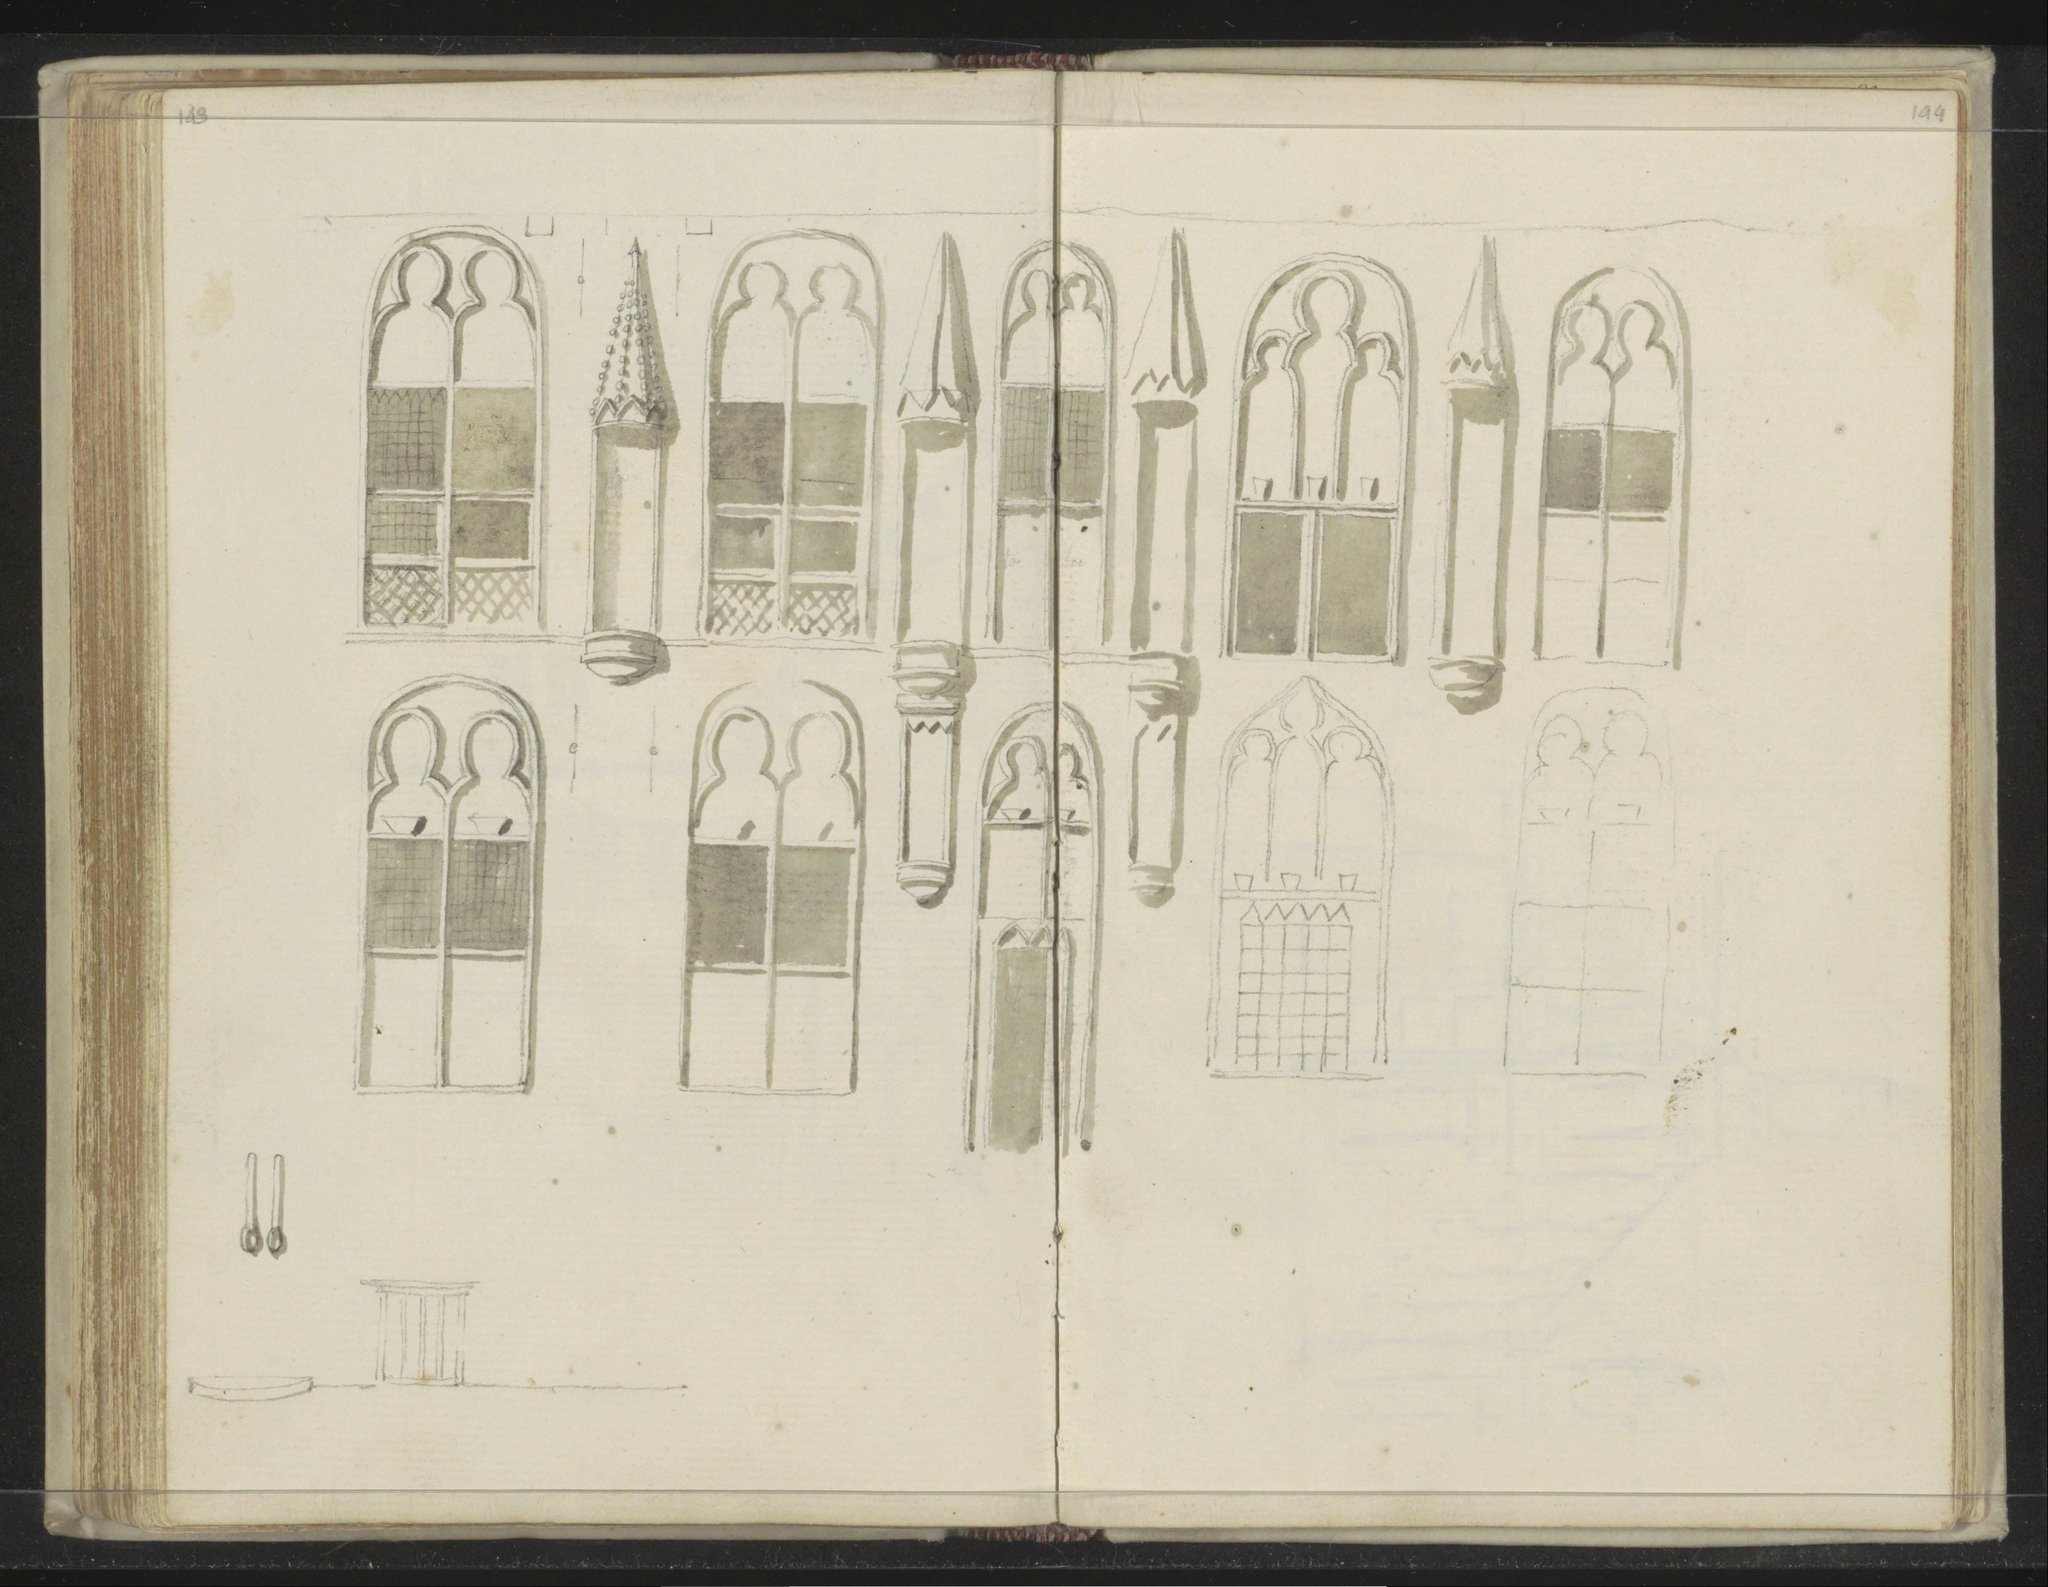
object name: sketchbook leaf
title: Gevel van een gebouw met maaswerkvensters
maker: johannes huibert prins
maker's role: draughtsman, painter, print maker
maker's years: 1757-1806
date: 1783-1797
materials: paper, pencil, watercolor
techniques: brush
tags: ornament ~ tracery, façade (of house or building)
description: Pagina 143 en 144 uit een schetsboek met 175 pagina's.